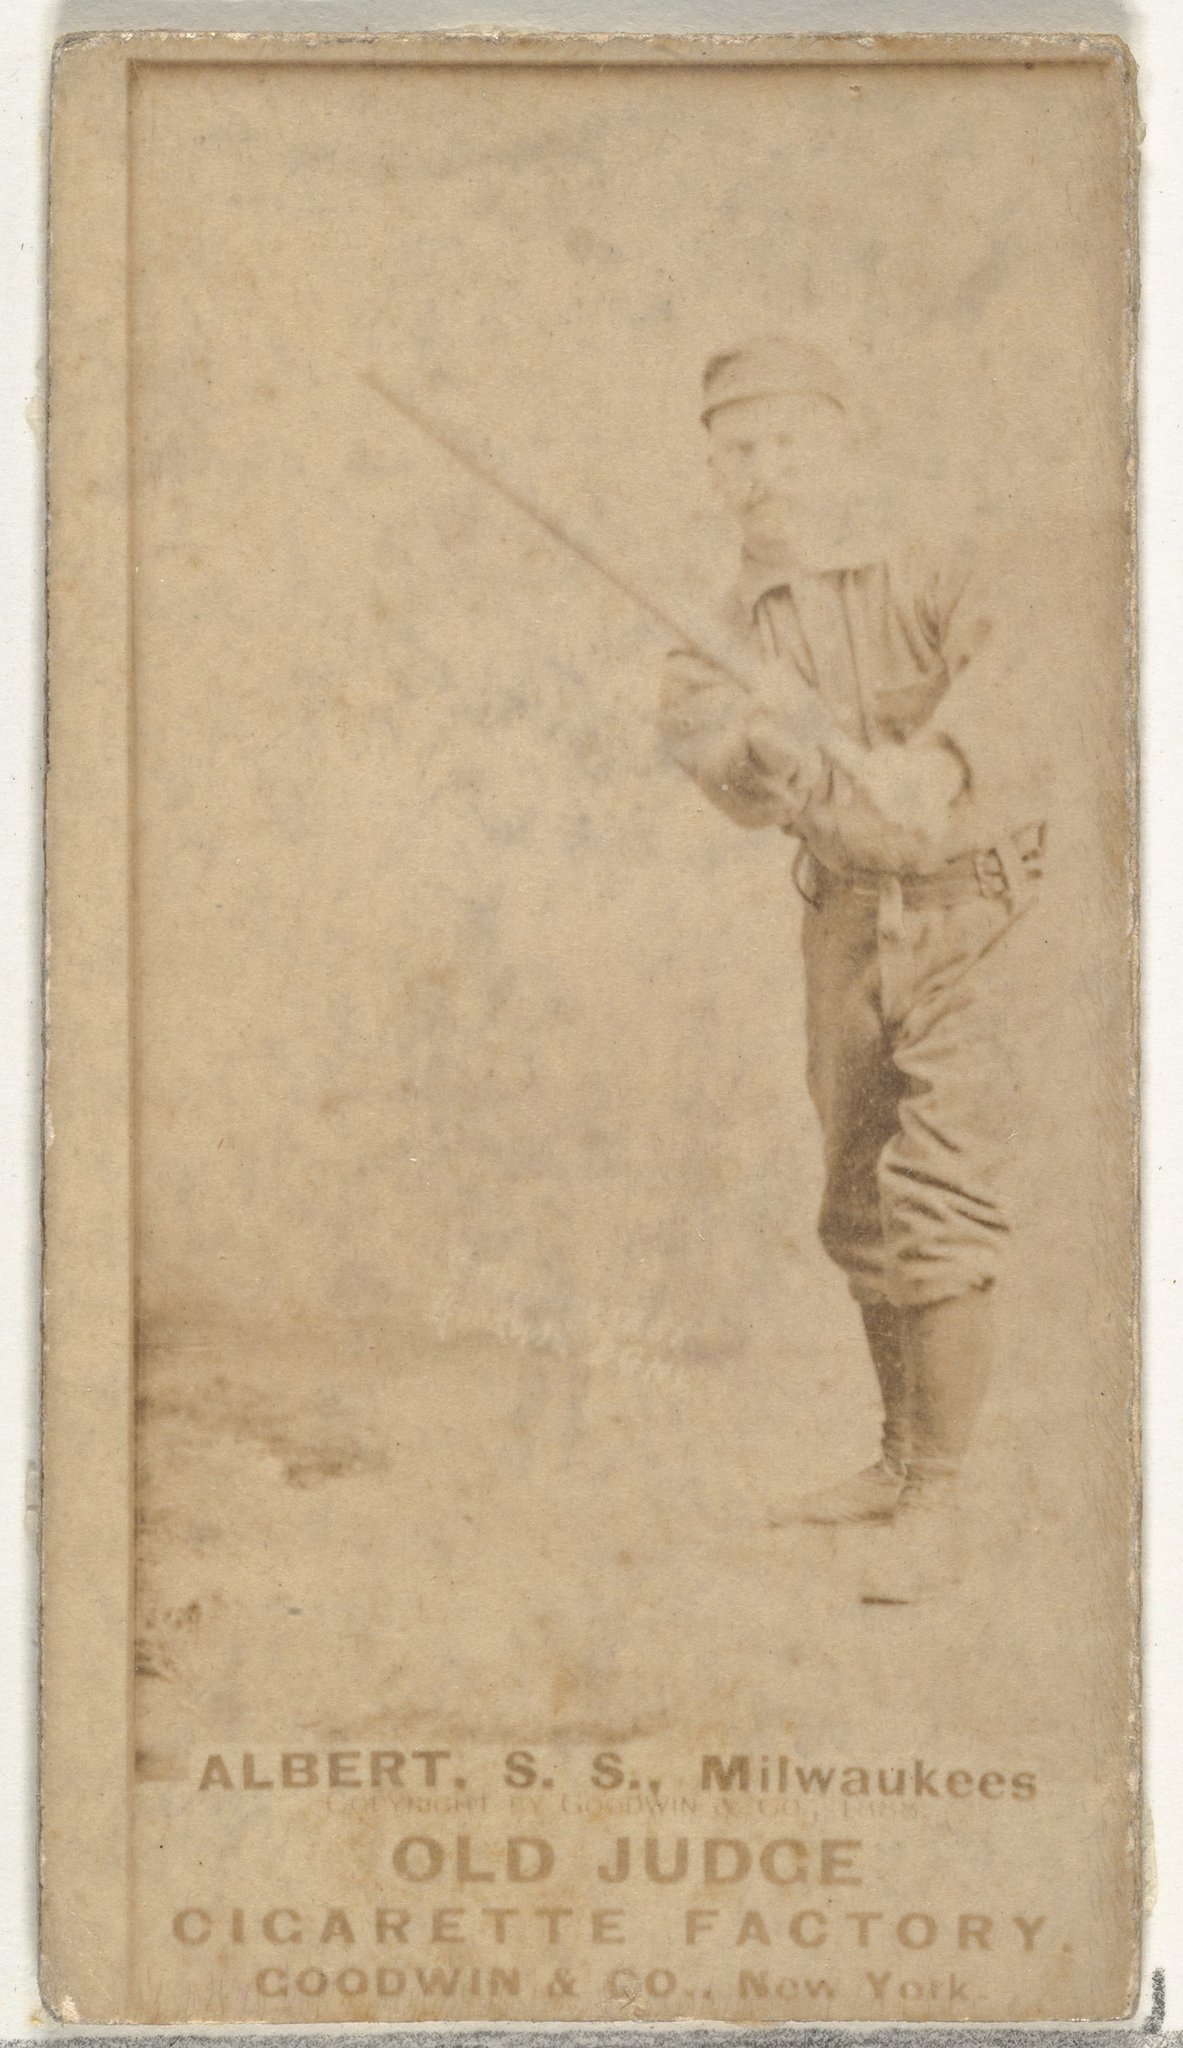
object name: baseball card, photograph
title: Augustus Peter "Gus" Alberts, Shortstop, Milwaukee, from the Old Judge series (N172) for Old Judge Cigarettes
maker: goodwin & company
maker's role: publisher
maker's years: 1850-1950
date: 1887-1890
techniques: albumen silver print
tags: men,baseball,athletes